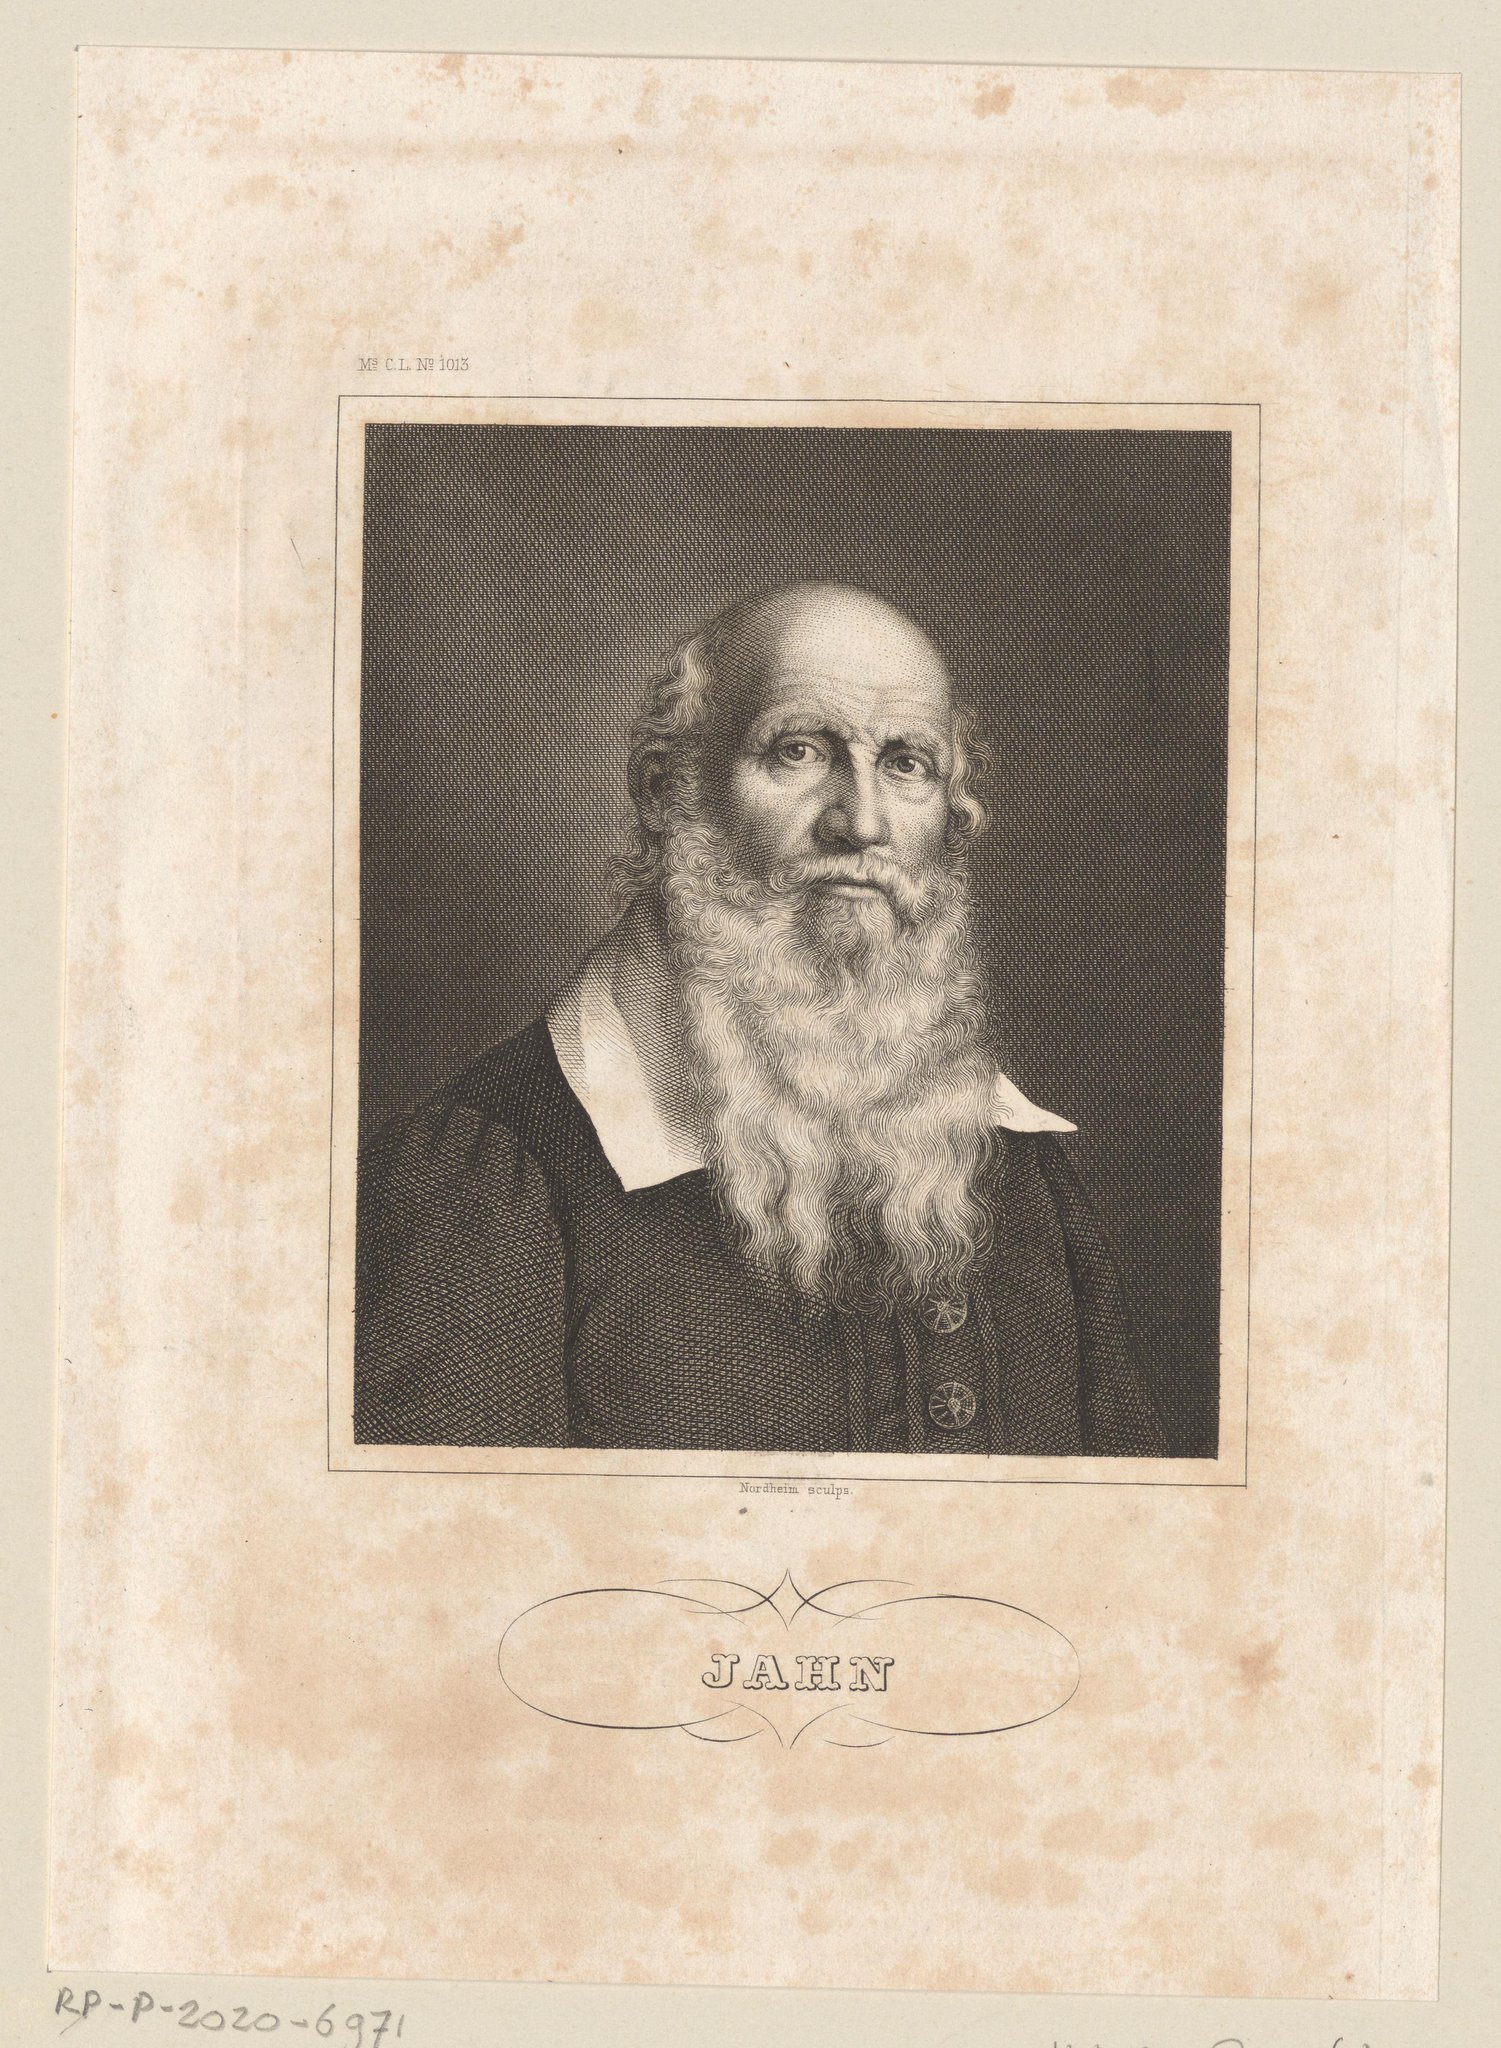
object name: print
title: Portret van Friedrich Ludwich Jahn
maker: johann georg nordheim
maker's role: print maker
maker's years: 1804-1853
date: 1840-1855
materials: paper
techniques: engraving, etching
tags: germany, education, science and learning, historical persons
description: Prent mogelijk uit: Meyer, Joseph. Das Grosse Conversations-Lexikon für die gebildeten Stände. Hildburghausen: Bibliographisches Institut, 1840-1855.